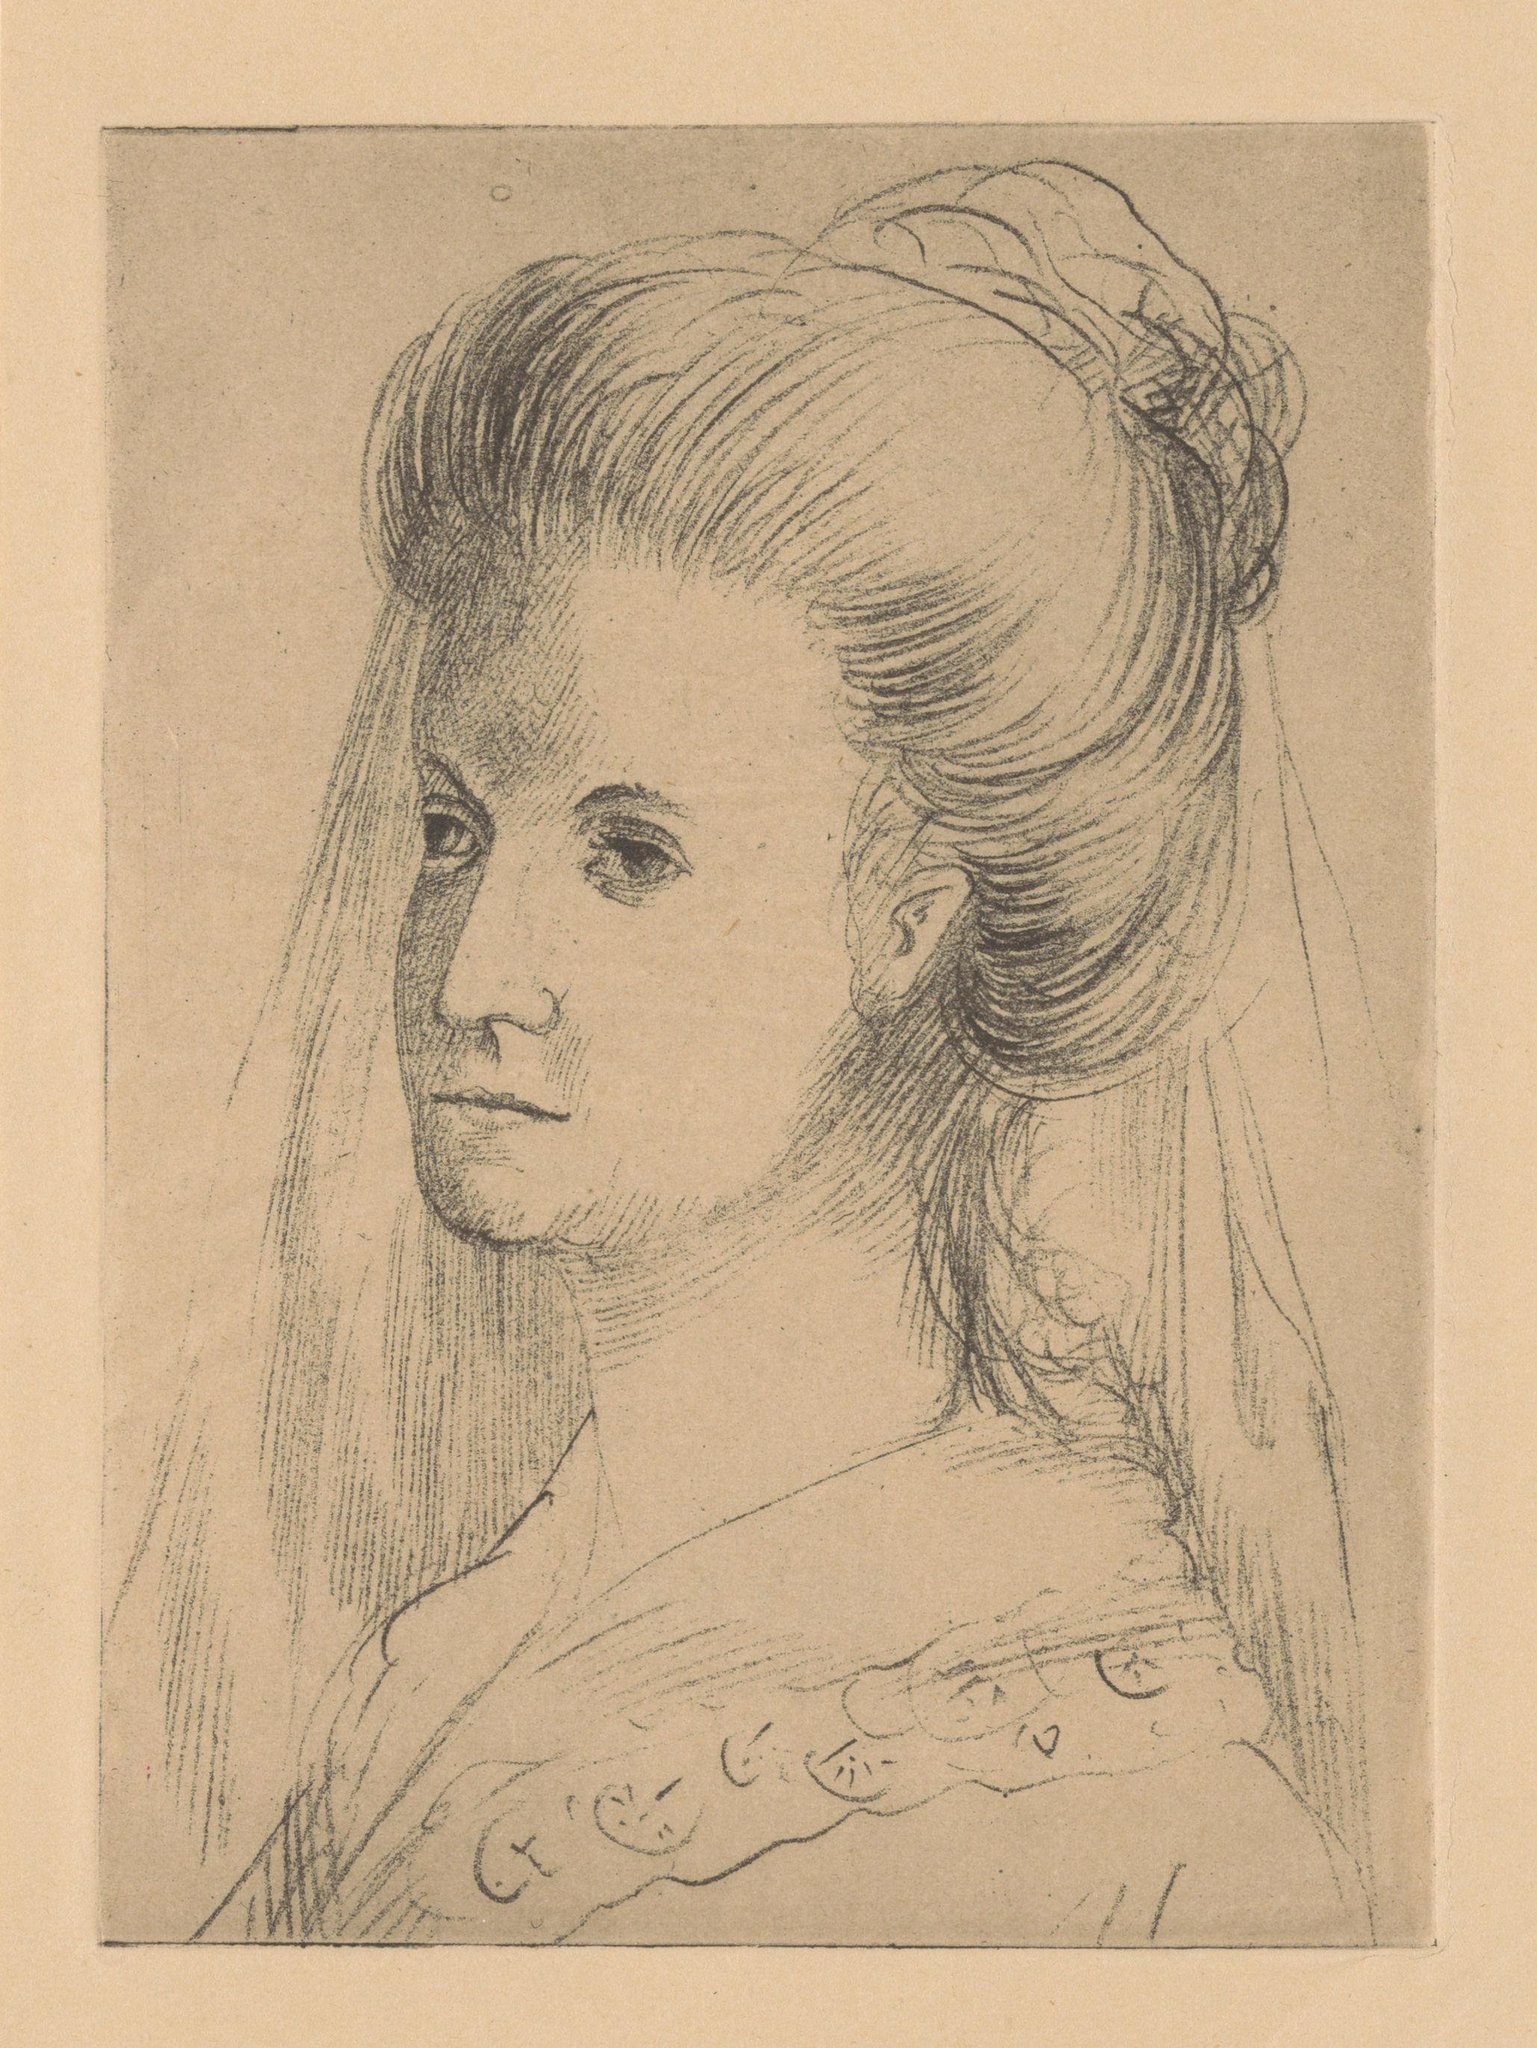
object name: print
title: Vrouw met sluier en opgestoken haar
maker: marius holleman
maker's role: draughtsman, print maker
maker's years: 1878-1926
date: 1904-1926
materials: paper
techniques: etching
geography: groningen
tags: veil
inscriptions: collector's mark: Lugt 2228